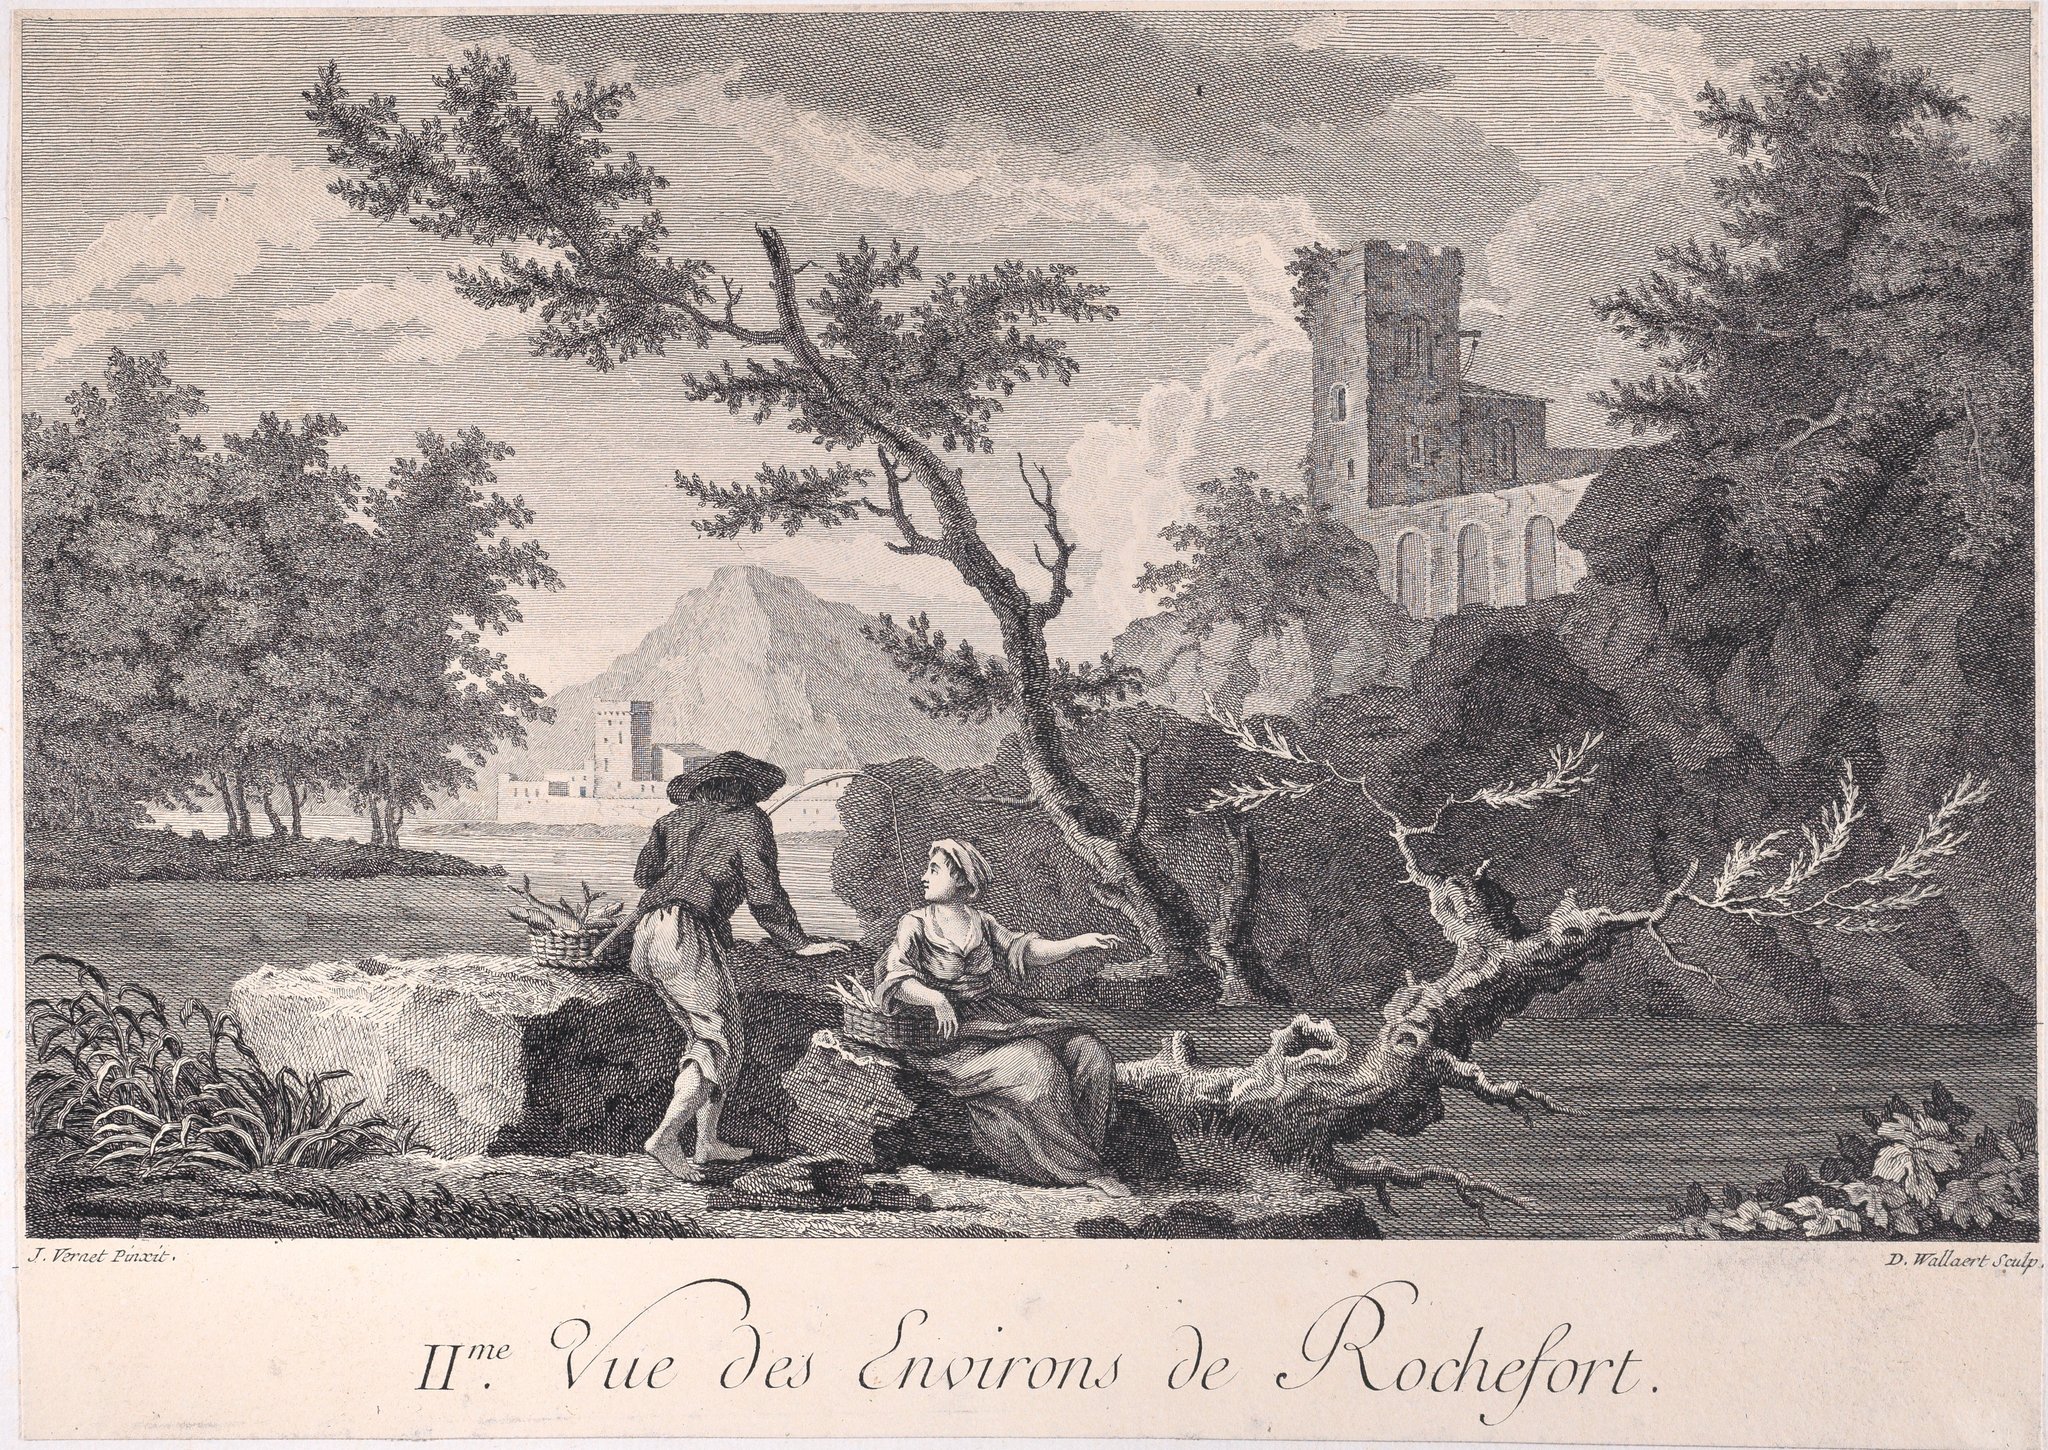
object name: print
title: Second View of the Surroundings of Rochefort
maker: joseph vernet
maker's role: artist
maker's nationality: french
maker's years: 1714-1789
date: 1750-1800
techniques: engraving